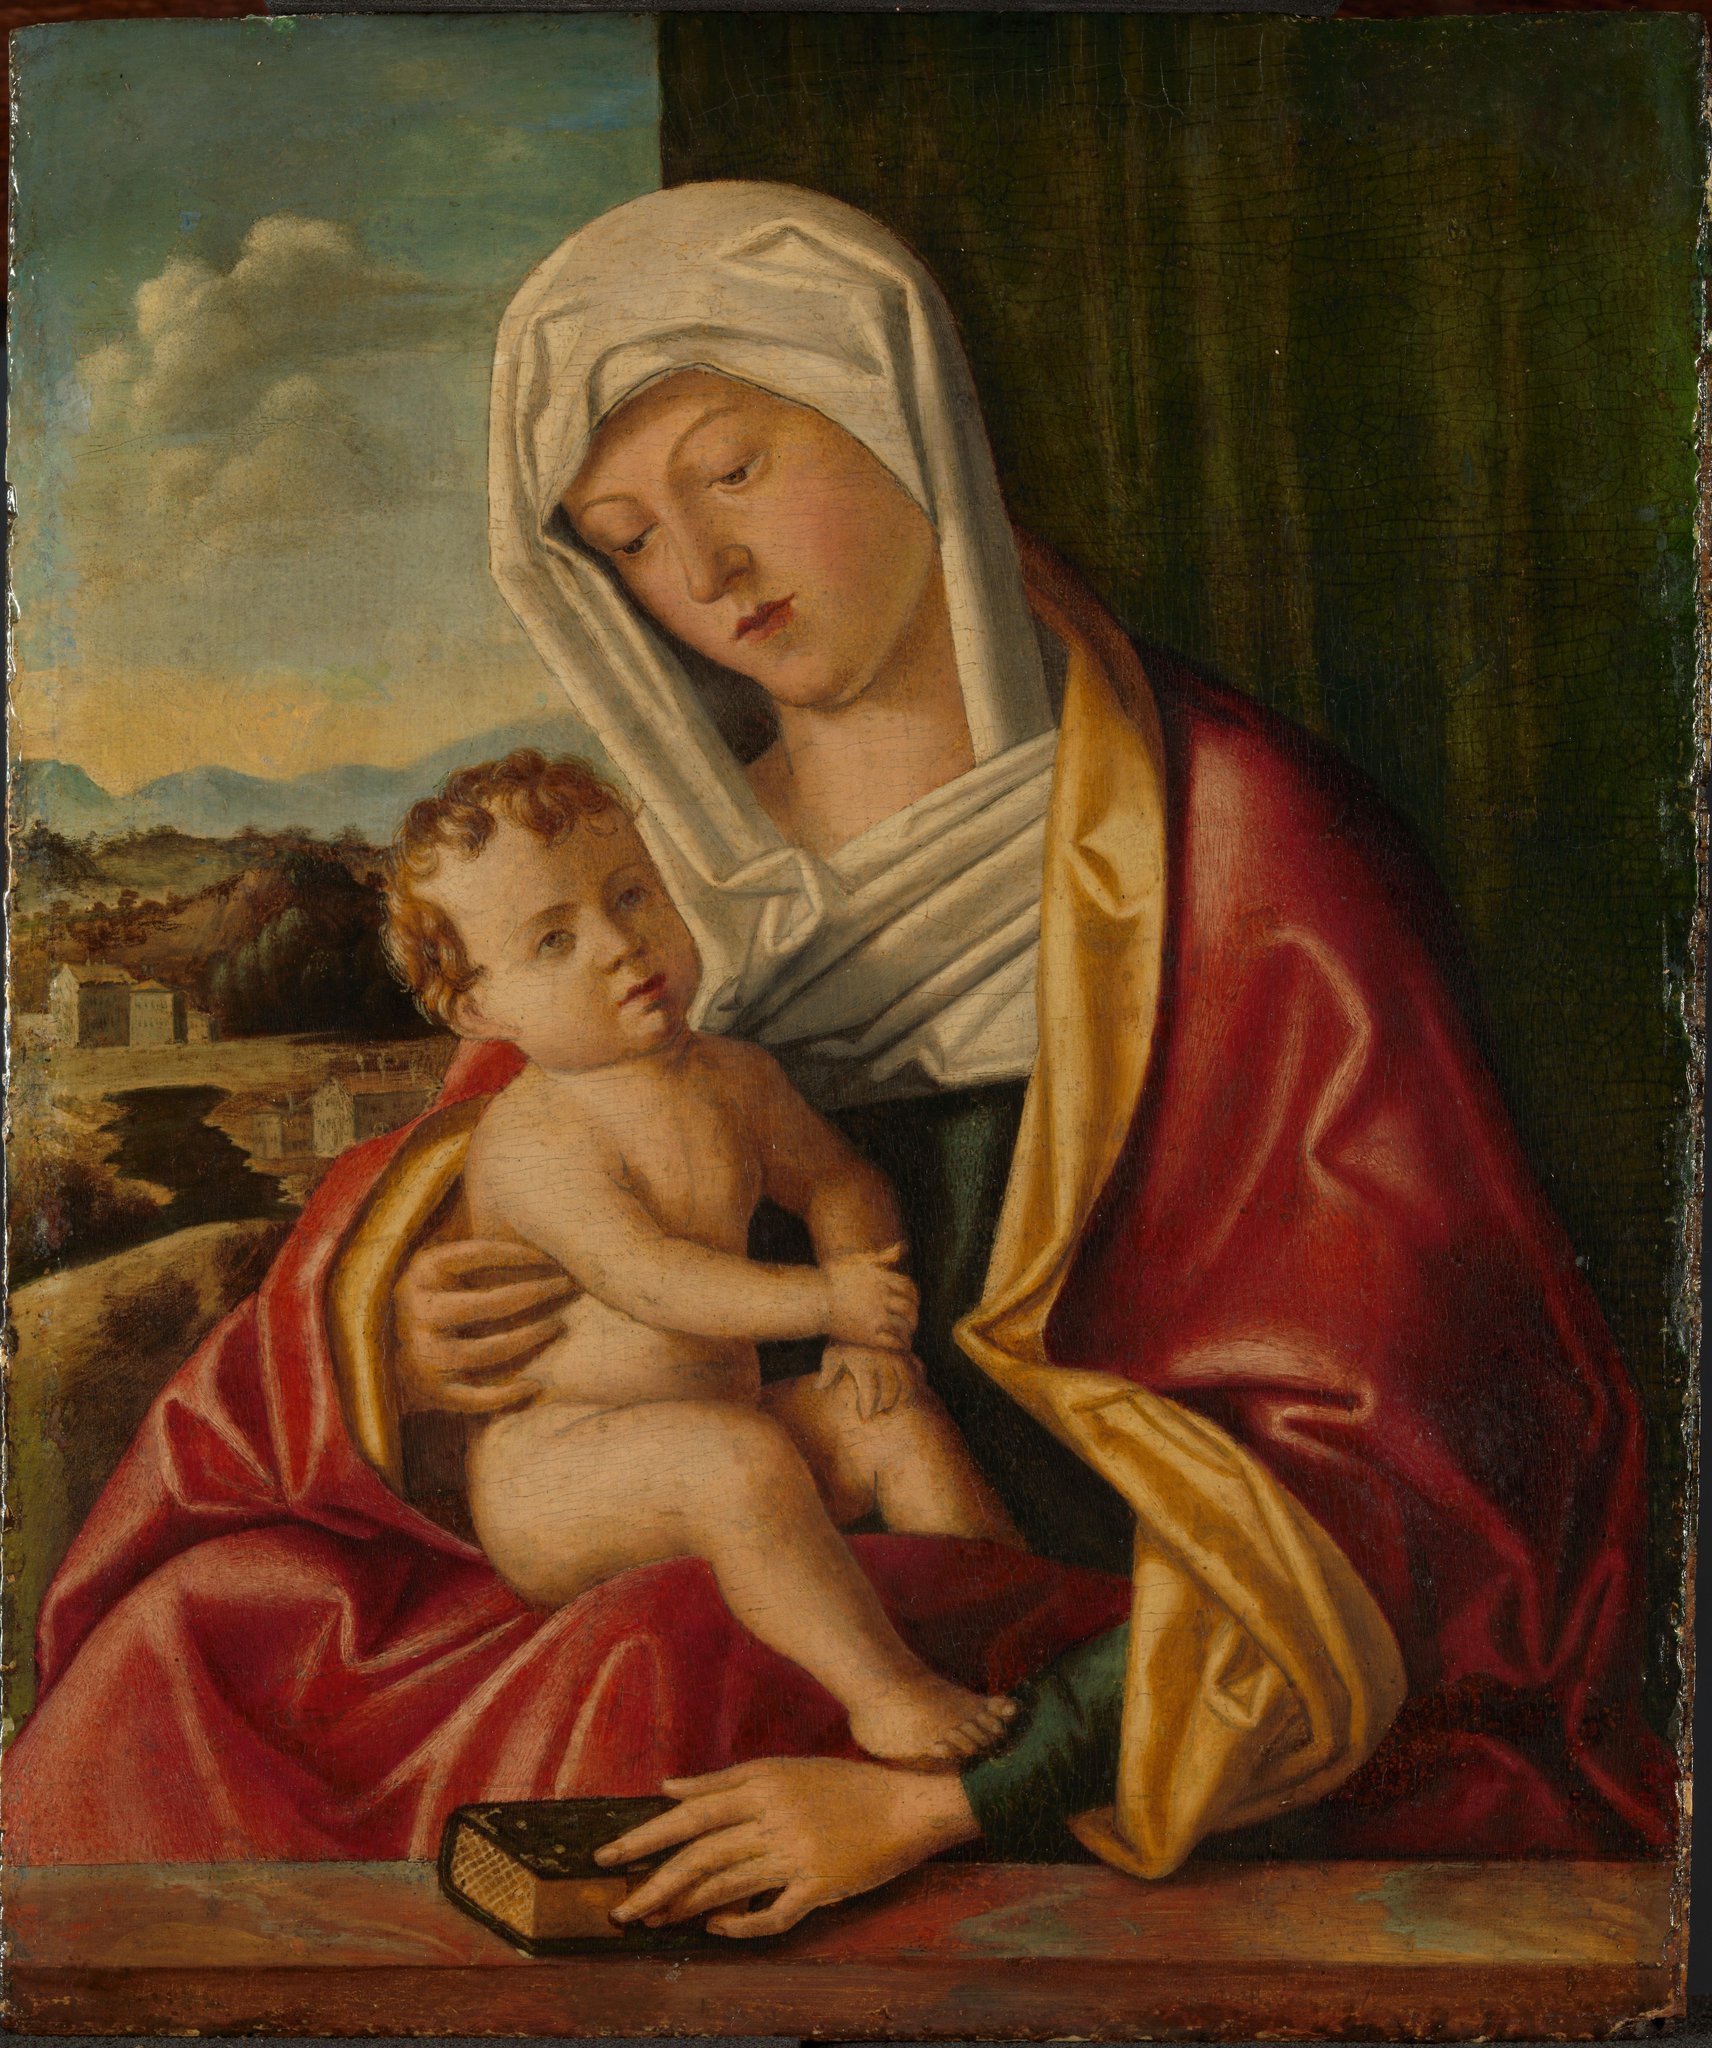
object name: painting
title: Madonna and Child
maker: giovanni bellini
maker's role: draughtsman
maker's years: 1430-1516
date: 1490-1520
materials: oil, panel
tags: madonna: mary sitting or enthroned, the christ-child in her lap (or in front of her bosom) (mary sometimes represented half-length)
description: Maria met kind. Maria zittend achter een balustrade met het Christuskind op schoot. In de linkerhand een boek.